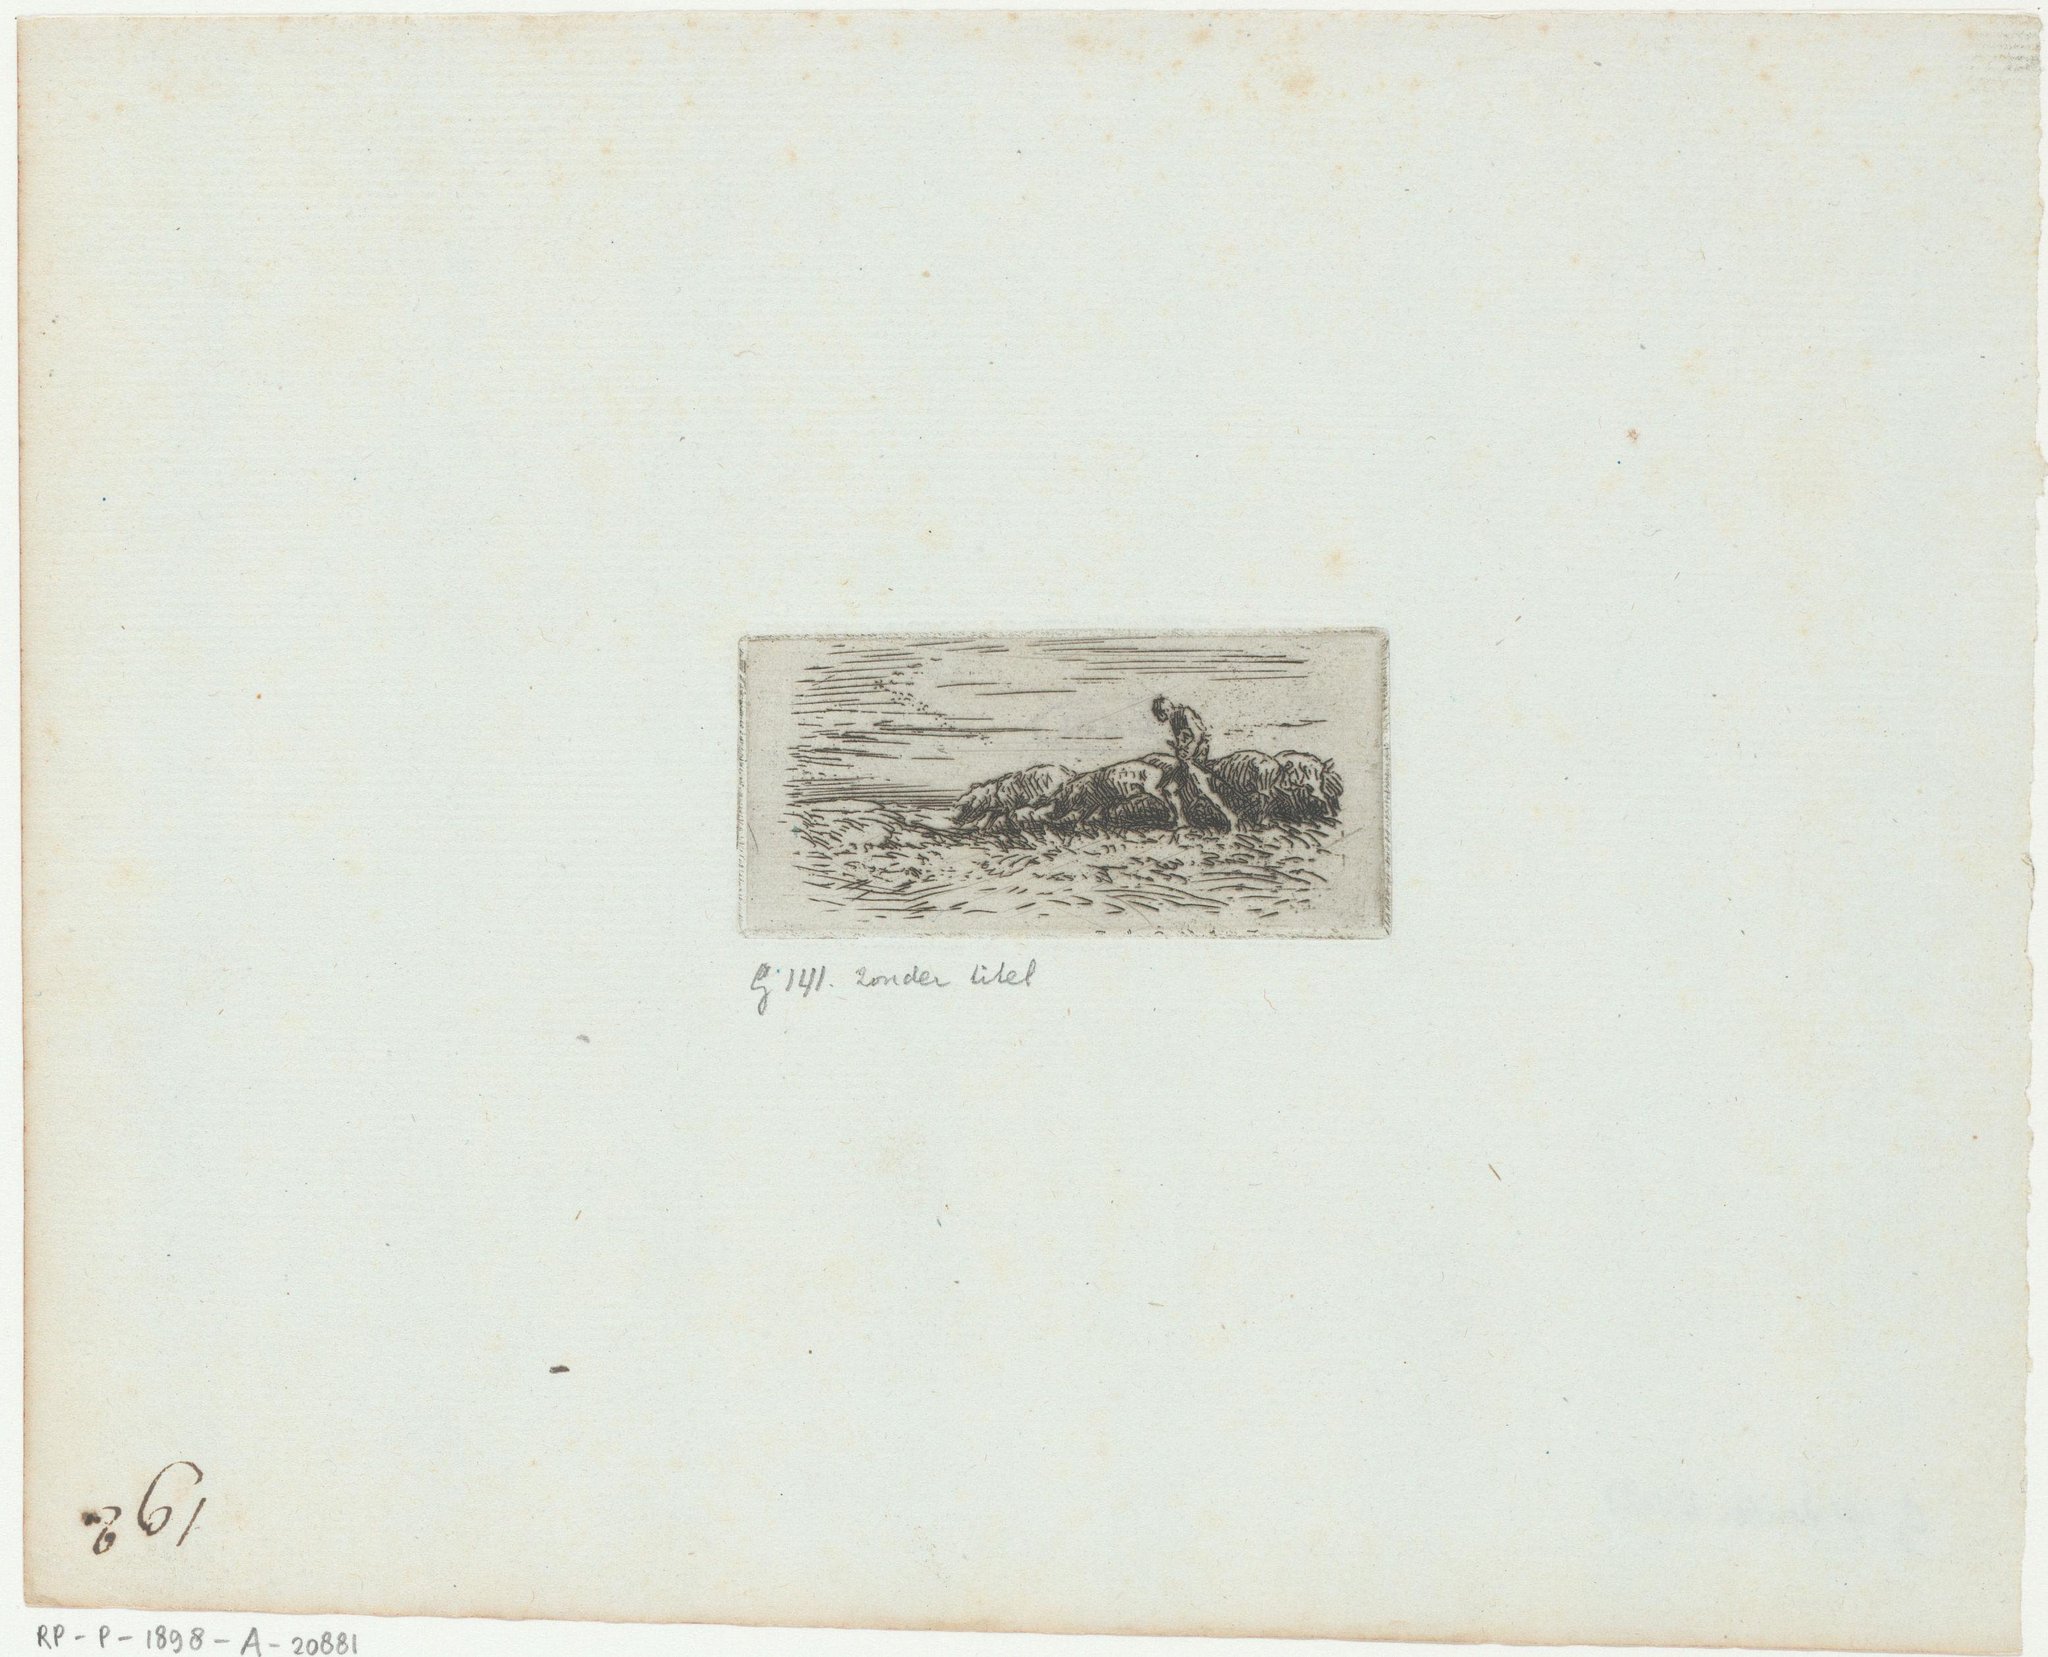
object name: titelprent, frontispice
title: Verschillende composities door Jacque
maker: charles emile jacque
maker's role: draughtsman, painter, print maker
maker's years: 1813-1894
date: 1849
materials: paper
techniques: drypoint, etching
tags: pig, herd, flock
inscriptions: number: ‘192’, collector's mark: Lugt 964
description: Volgens de literatuur betreft dit de titelprent voor een zesdelige serie met verschillende onderwerpen door Jacque, uitgegeven in 1849.